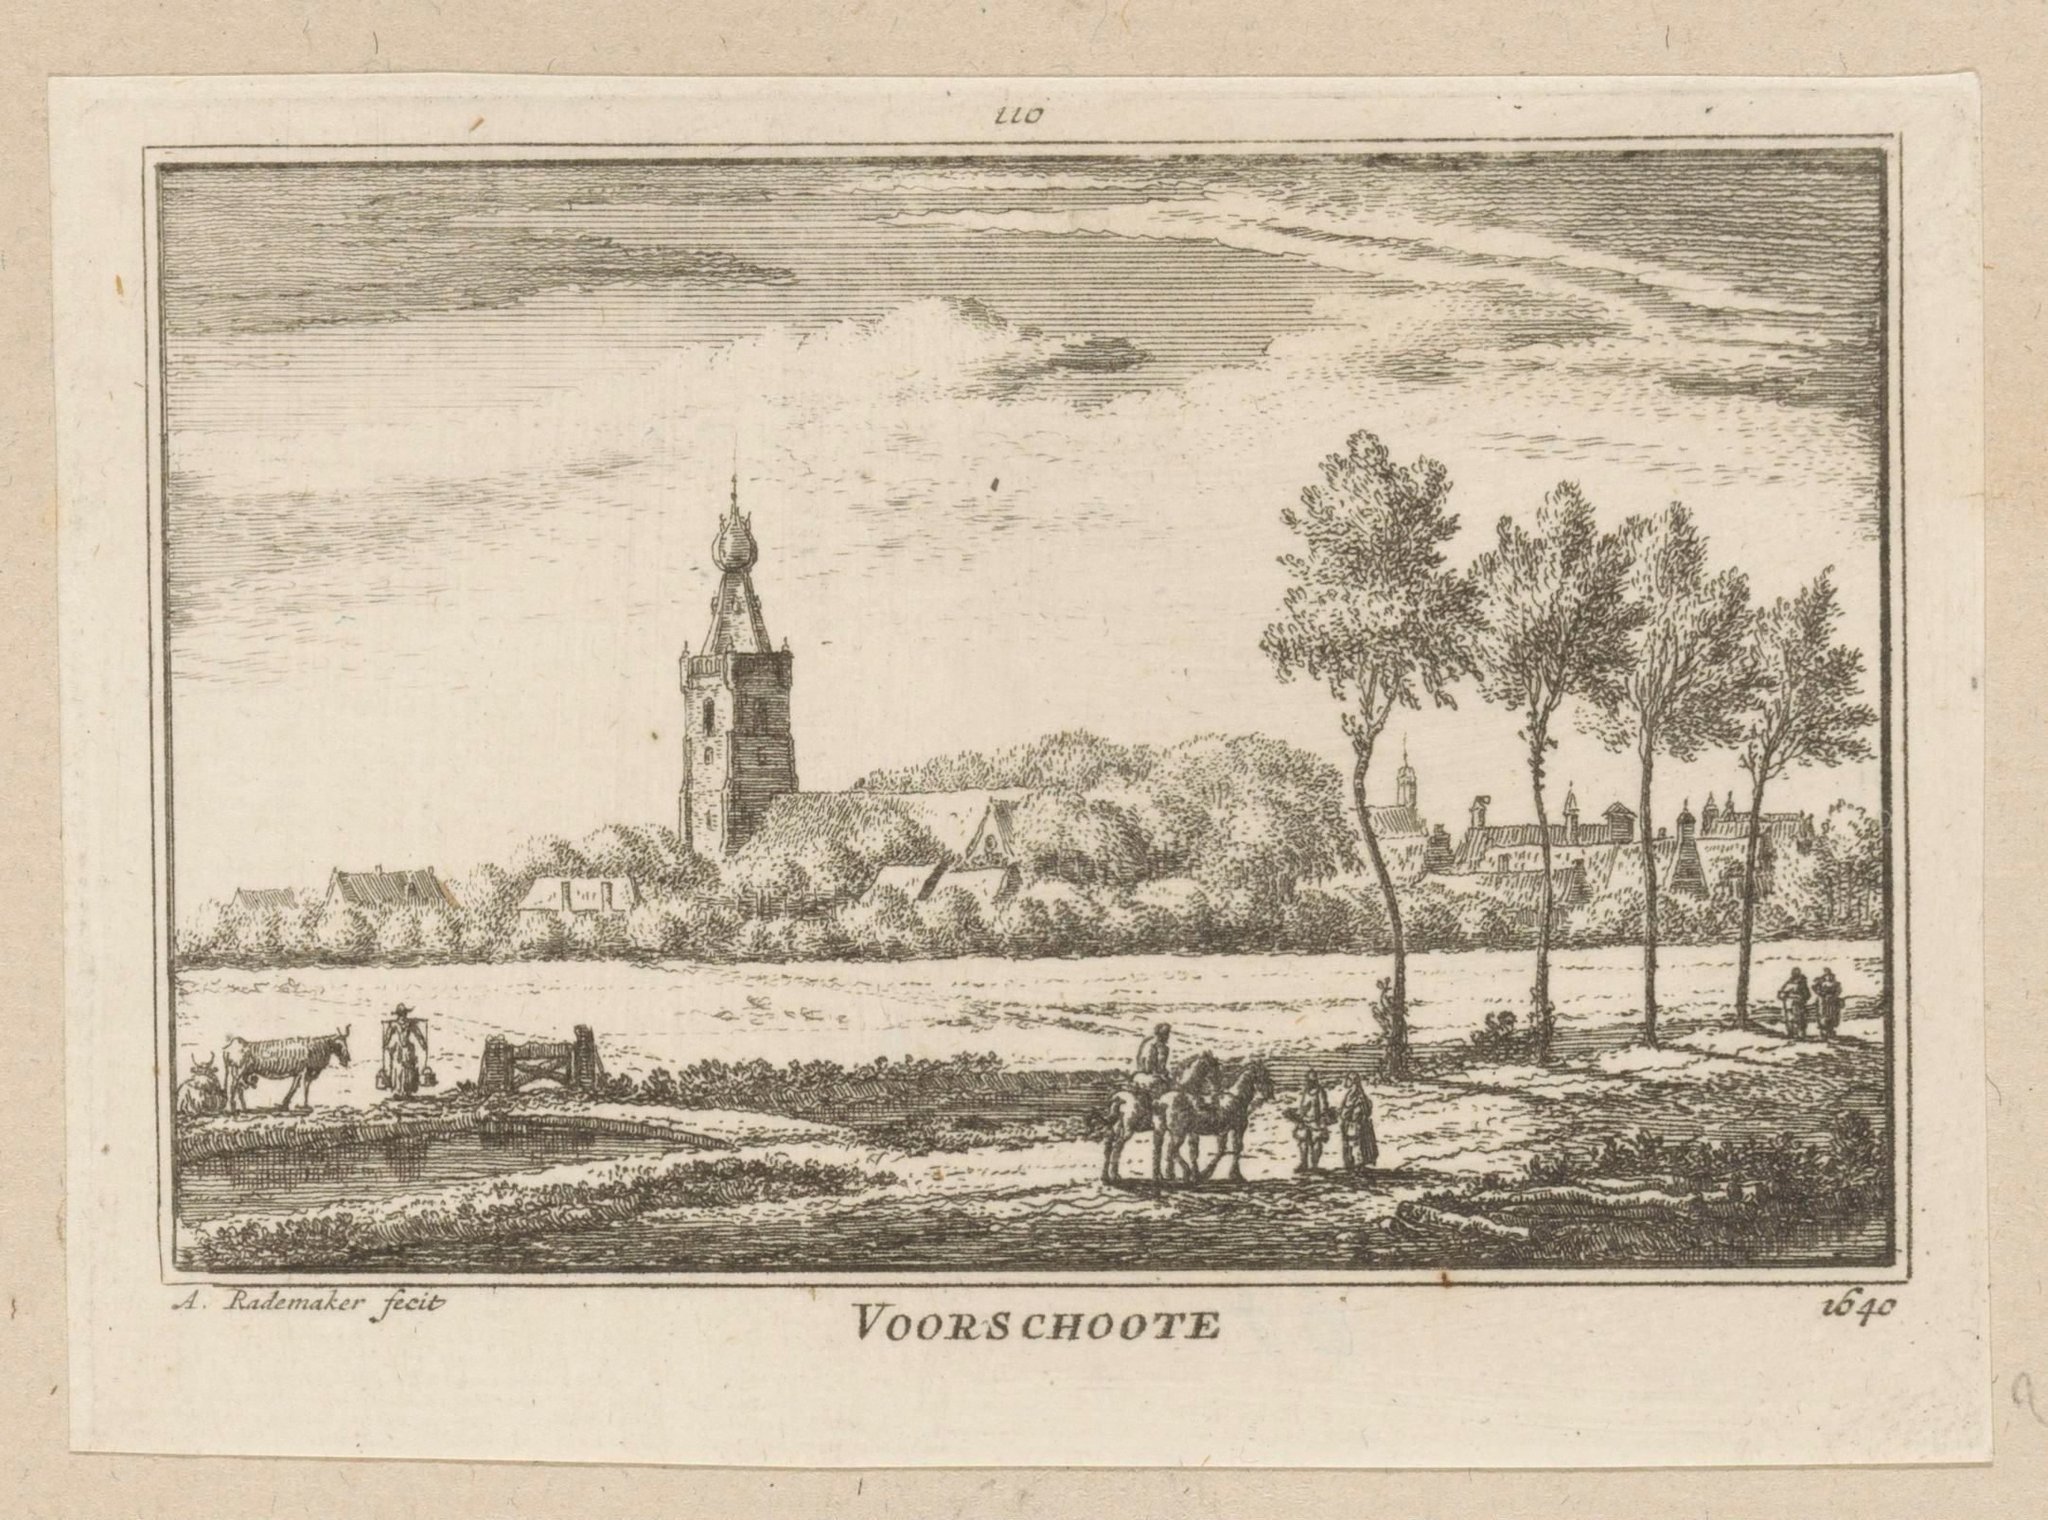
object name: print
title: Voorschoote 1640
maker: abraham rademaker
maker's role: draughtsman, print maker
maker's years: 1676-1735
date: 1725-1803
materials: paper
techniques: engraving, etching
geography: amsterdam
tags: riding a horse, ass, or mule; rider, horseman, prospect of village, silhouette of village, cow, farmers - aa - female farmer, farmer's wife, church (exterior), voorschoten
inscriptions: collector's mark: Lugt 2228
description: Prent ook gebruikt in: Rademaker, Abraham. Kabinet van Nederlandsche outheden en gezichten: vervat in 300 konstplaaten (…). 2 delen. Amsterdam: Willem Barents, 1725, dl. 1, ill. 110. Na 1725 is deze prent nog in verschillende heruitgaven verschenen, uitgegeven in 1727-1733, 1770-1771 en 1792-1803. Uit welke uitgave het huidige exemplaar precies komt is niet na te gaan.